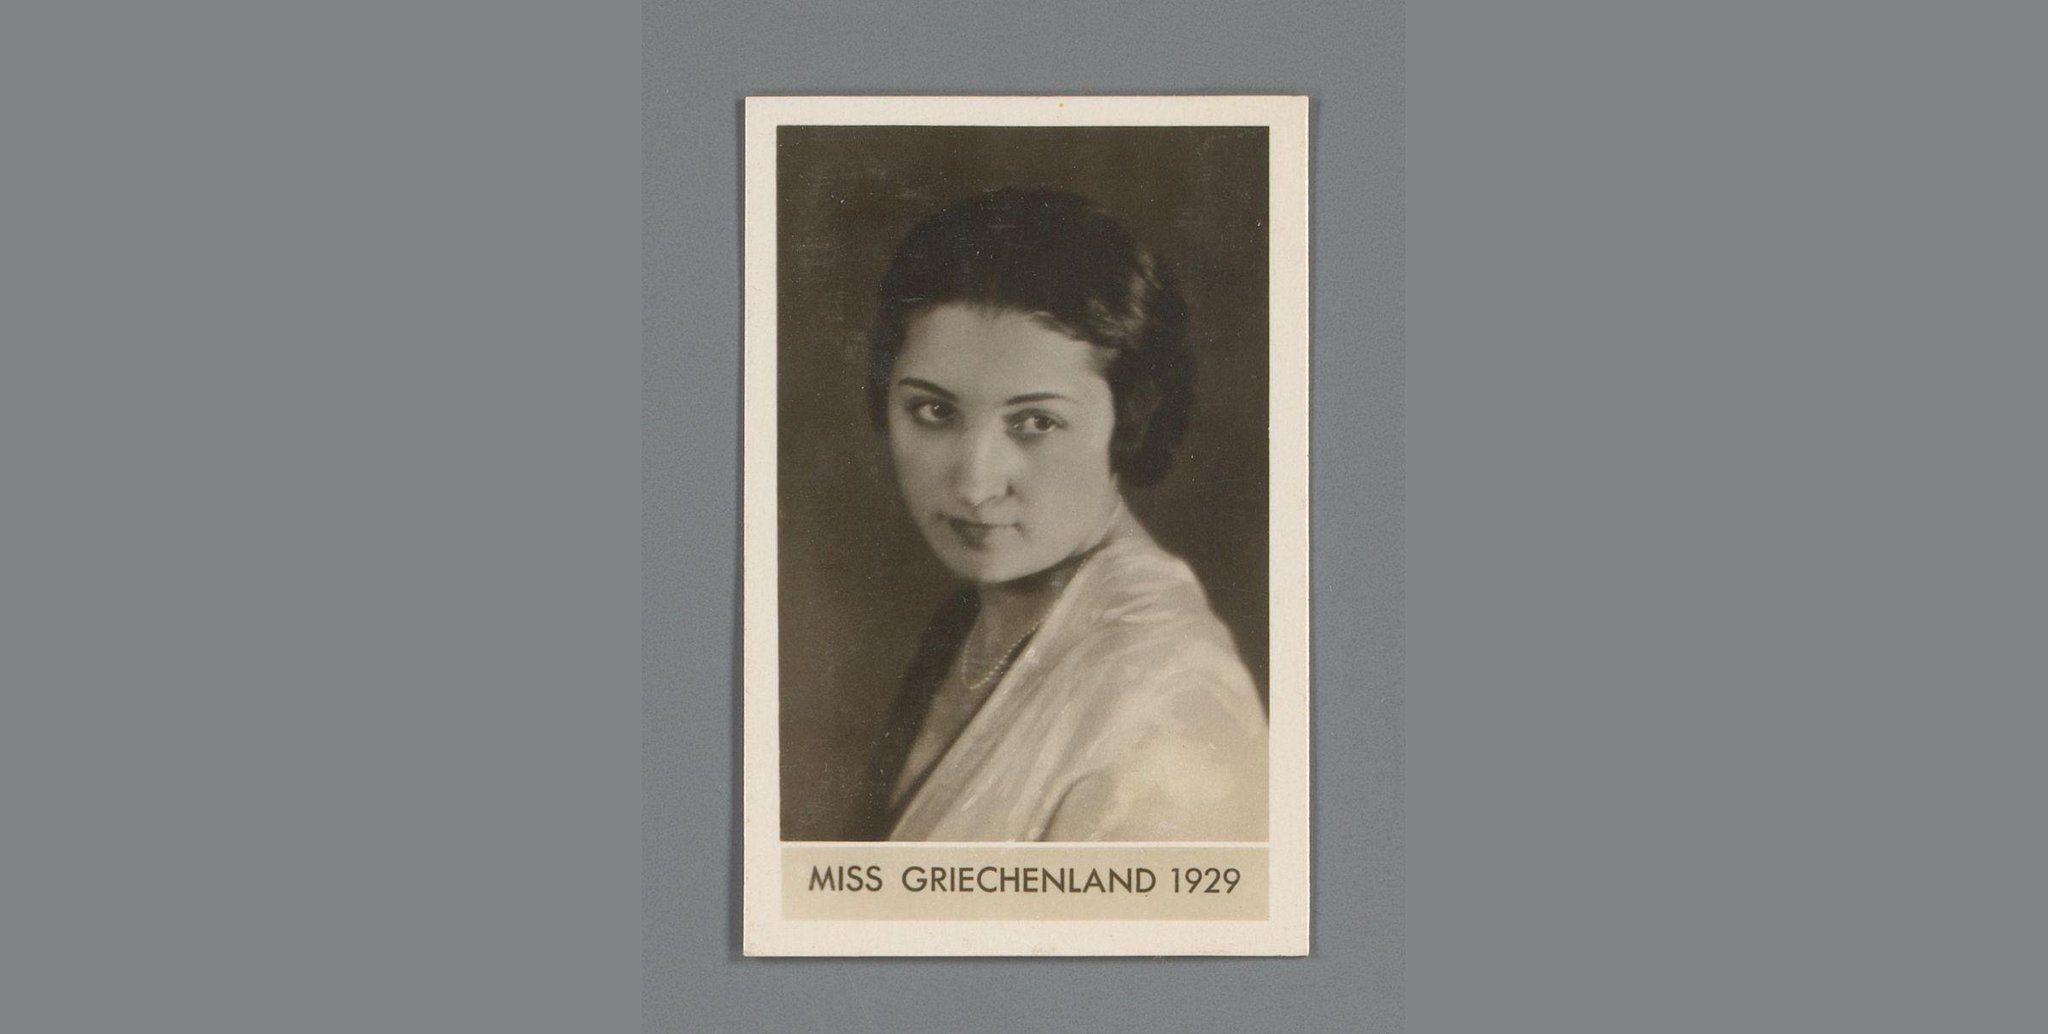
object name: photograph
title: Portret van Aspasie Karatja, Miss Griekenland 1929, reclame voor Club & Liga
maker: Anonymous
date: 1929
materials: paper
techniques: gelatin silver print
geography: dresden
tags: historical persons - bb - woman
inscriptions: inscription: ‘Die schönsten/ Frauen der Welt/ dargestellt durch die Schön-/ heitsköniginnen aller Länder,/ finden Sie in 190 echten/ Bromsilber-Fotos, die nur den/ CLUB-und-LIGA-Packun-/ gen beiliegen. Eind prächtiges/ Sammel-Album erhalten Sie/ für 75 Pfennig vom Händler/ oder bei Einsendung von/ 75 Pfennig in Briefmarken/ von der Bilderstelle Lohse,/ Dresden A24, Nossener Str. 1./ Ges. gesch. Nachdruck verboten!’